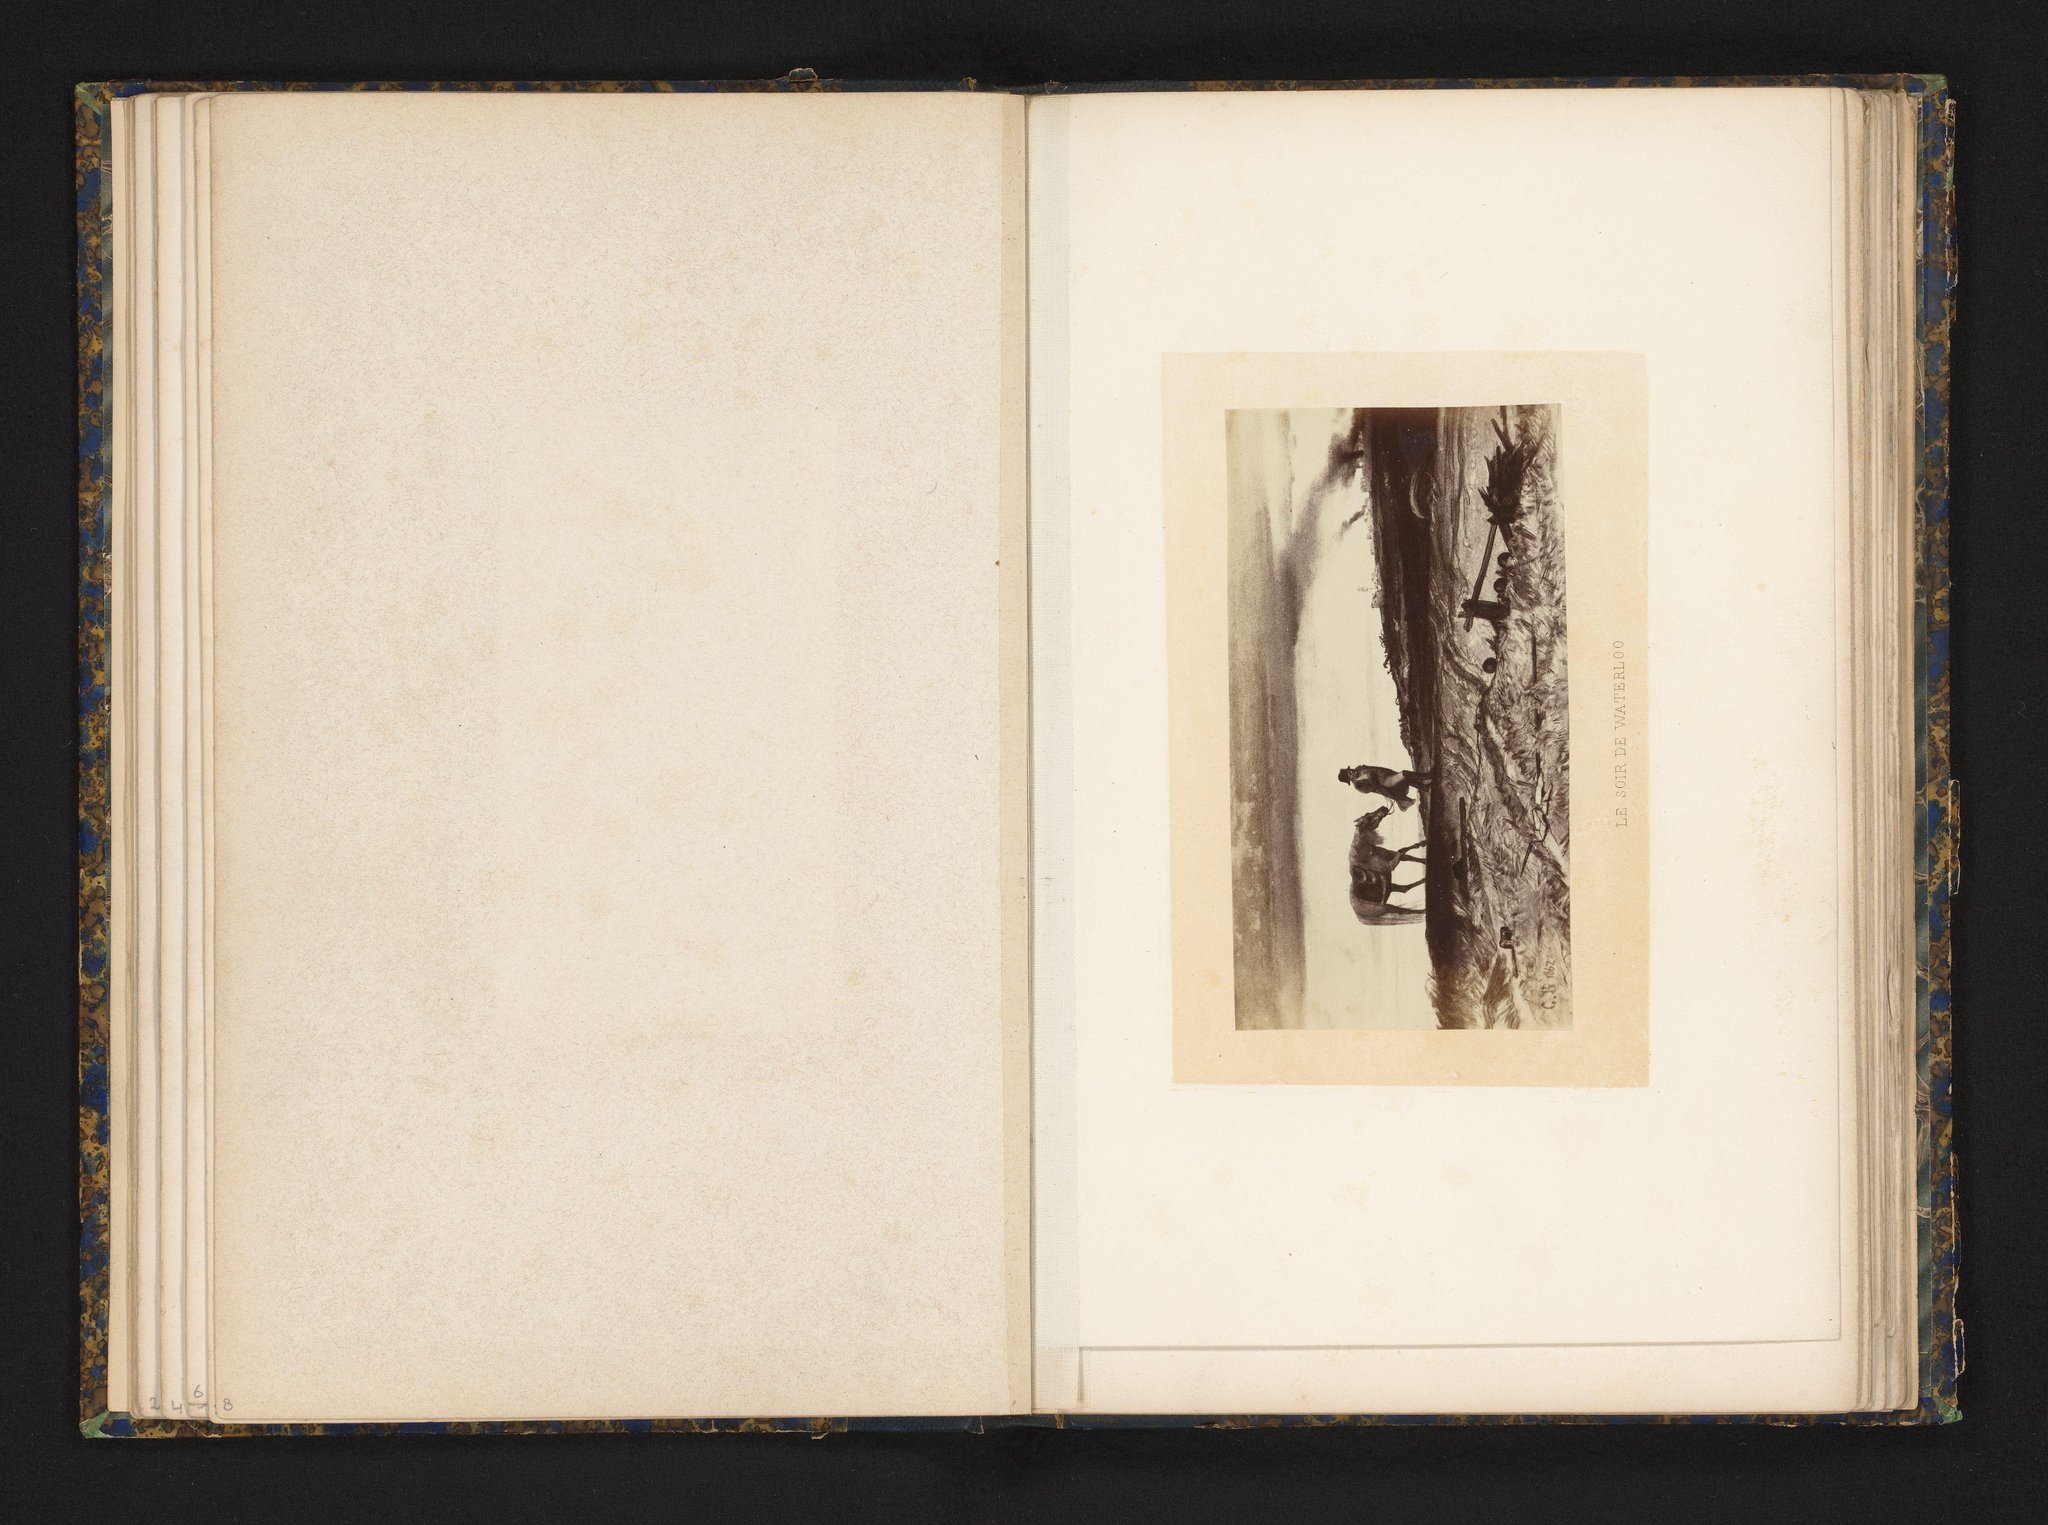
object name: reproduction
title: Fotoreproductie van een tekening van de Slag bij Waterloo uit Les Misérables van Victor Hugo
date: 1862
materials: photographic support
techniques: albumen print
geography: paris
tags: literary characters and objects